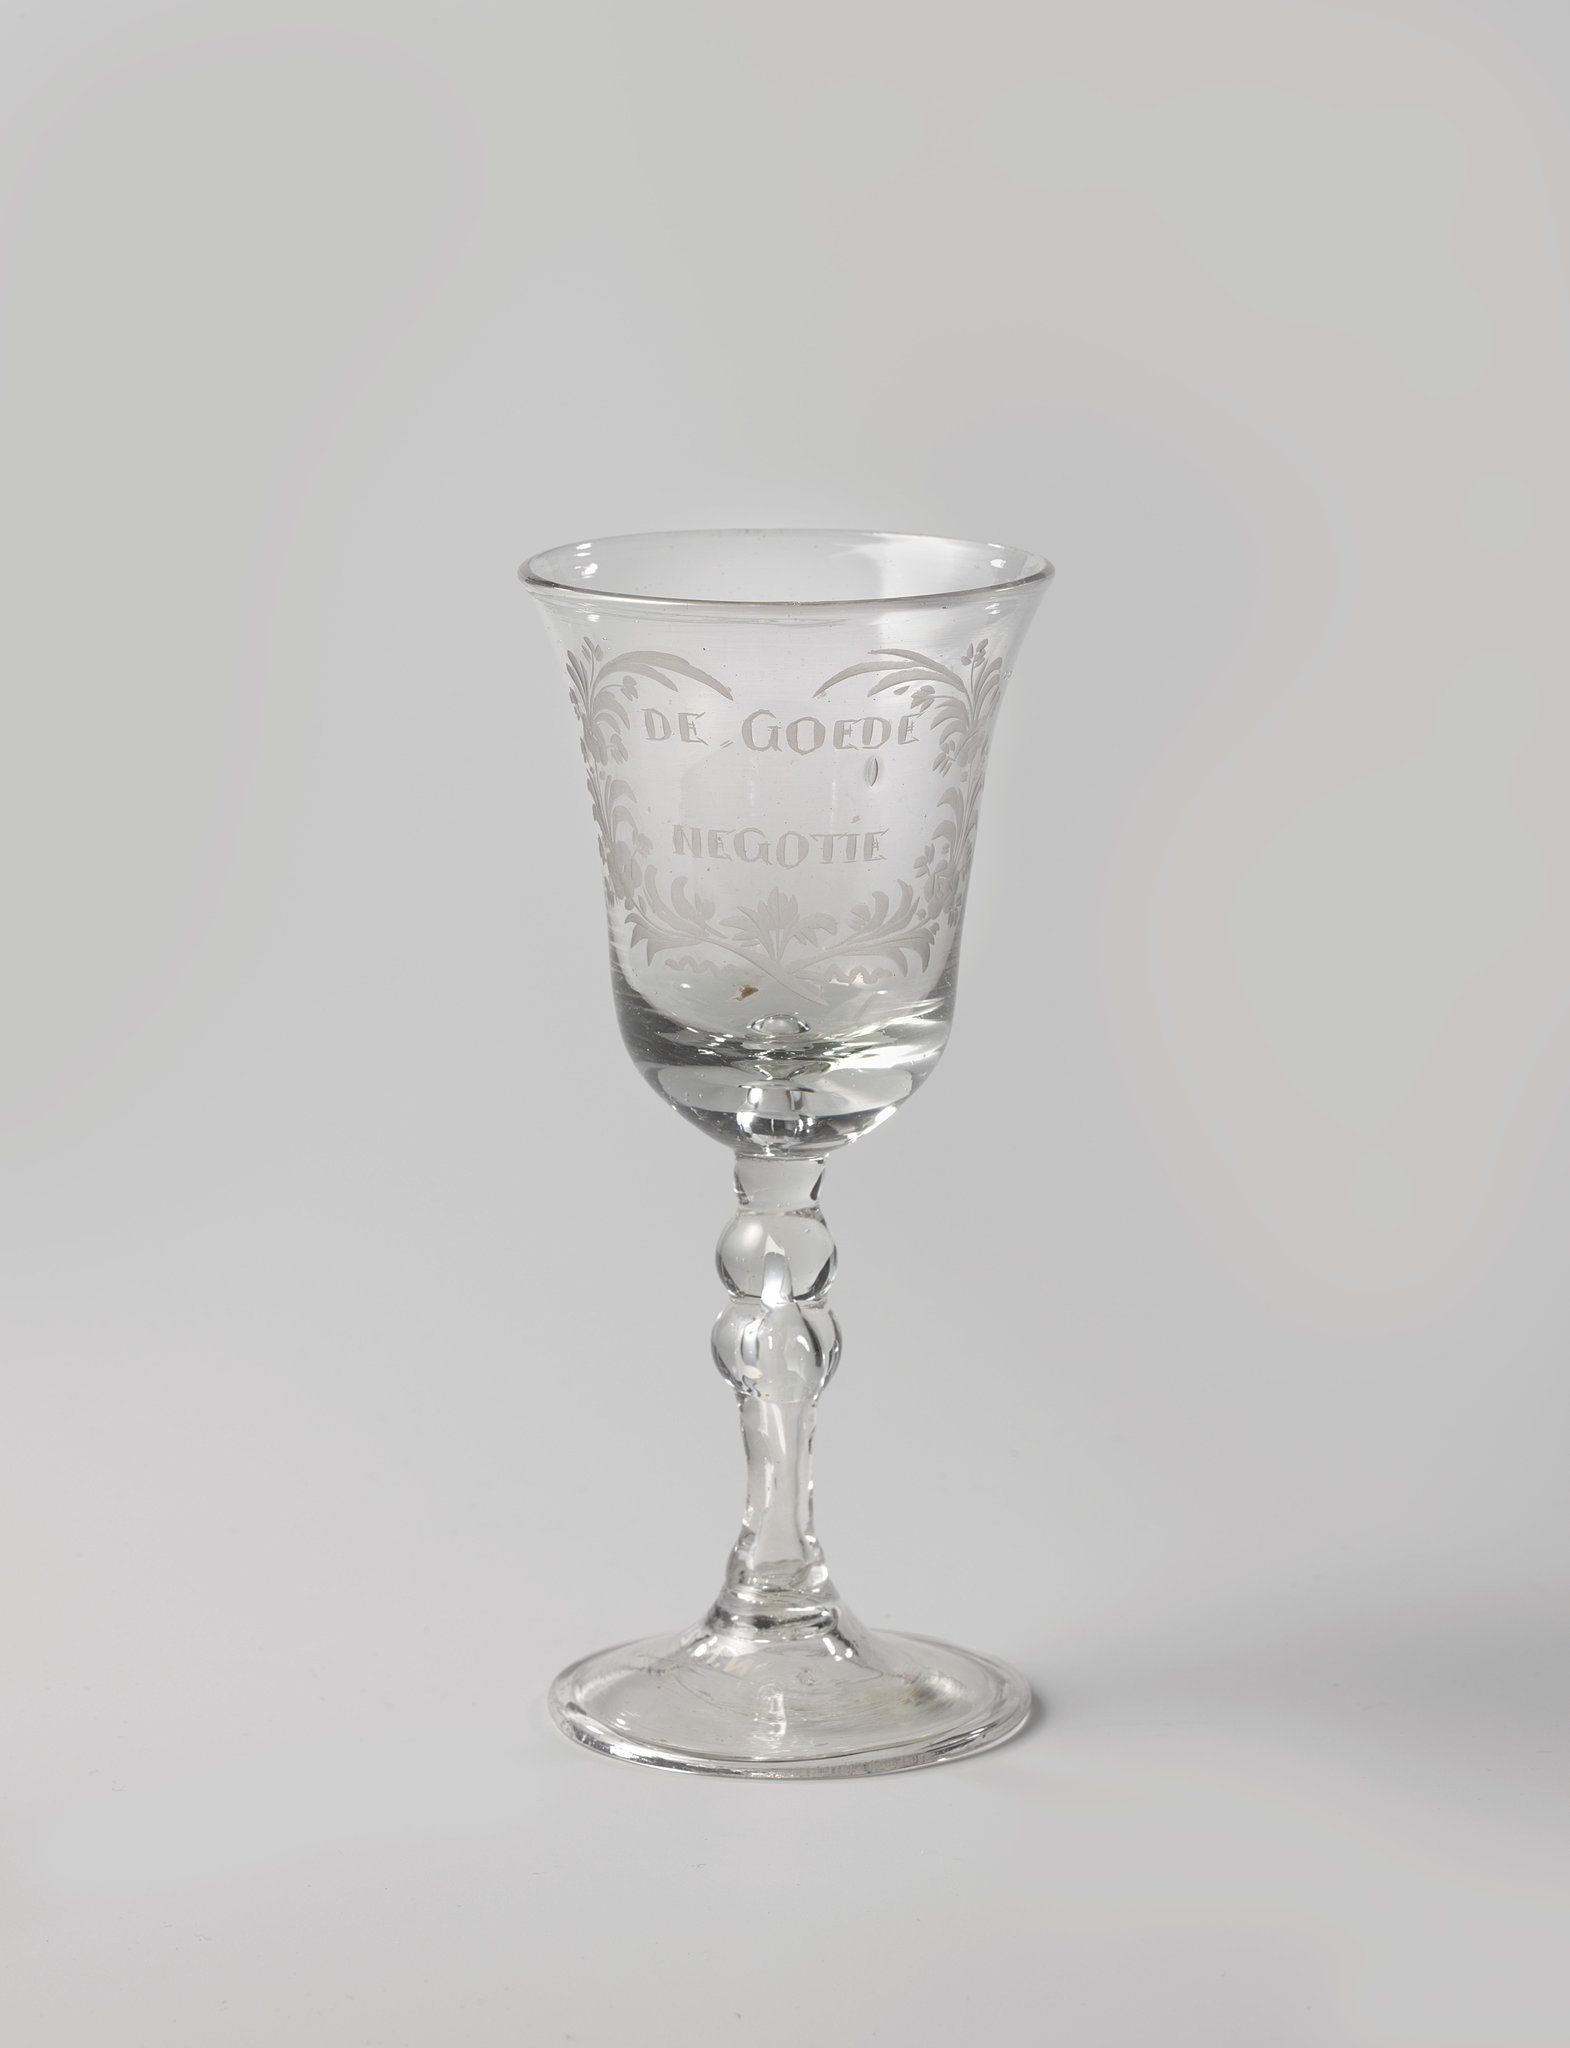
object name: goblet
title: Kelkglas met het opschrift: DE GOEDE NEGOTIE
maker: Anonymous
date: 1725-1750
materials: glass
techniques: glassblowing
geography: central germany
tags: zierikzee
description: Gewelfde voet met omgeslagen rand. Balusterstam met twee knopen en een langgerekte luchtbel. Klokvormige kelk met afgeronde, massieve bodem, waarin een luchtbel is gestoken. Op de kelk het gegraveerde opschrift: DE GOEDE NEGOTIE tussen twee ranken.